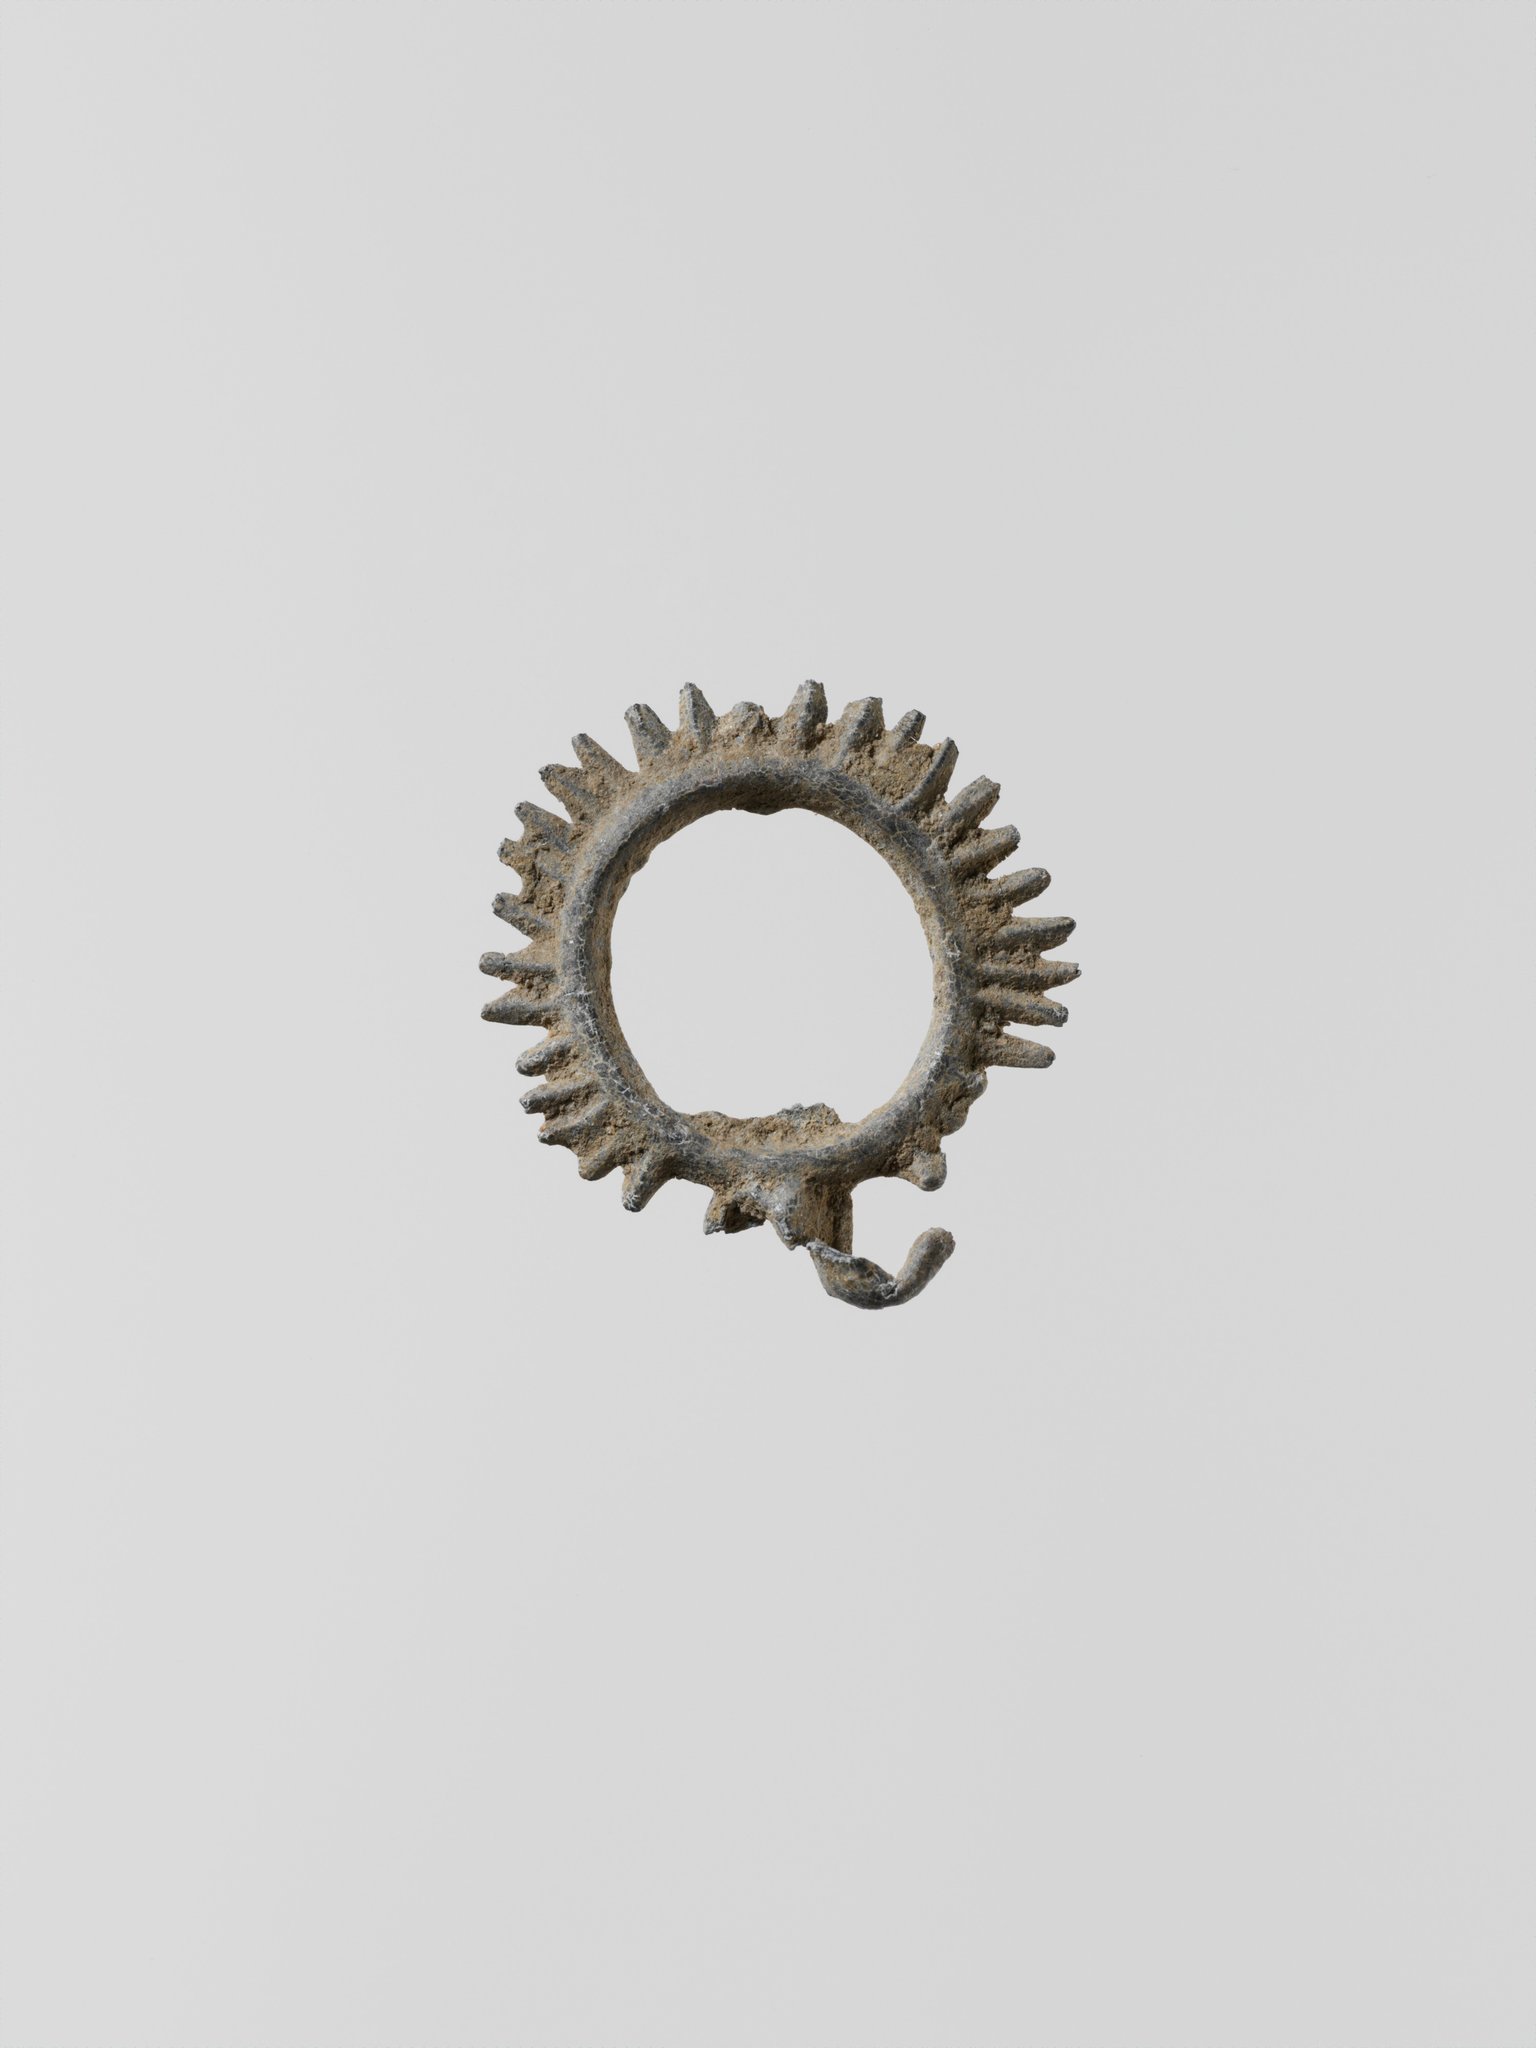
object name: wreath, 11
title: Lead wreath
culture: greek, laconian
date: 600-401 BCE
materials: lead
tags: wreaths